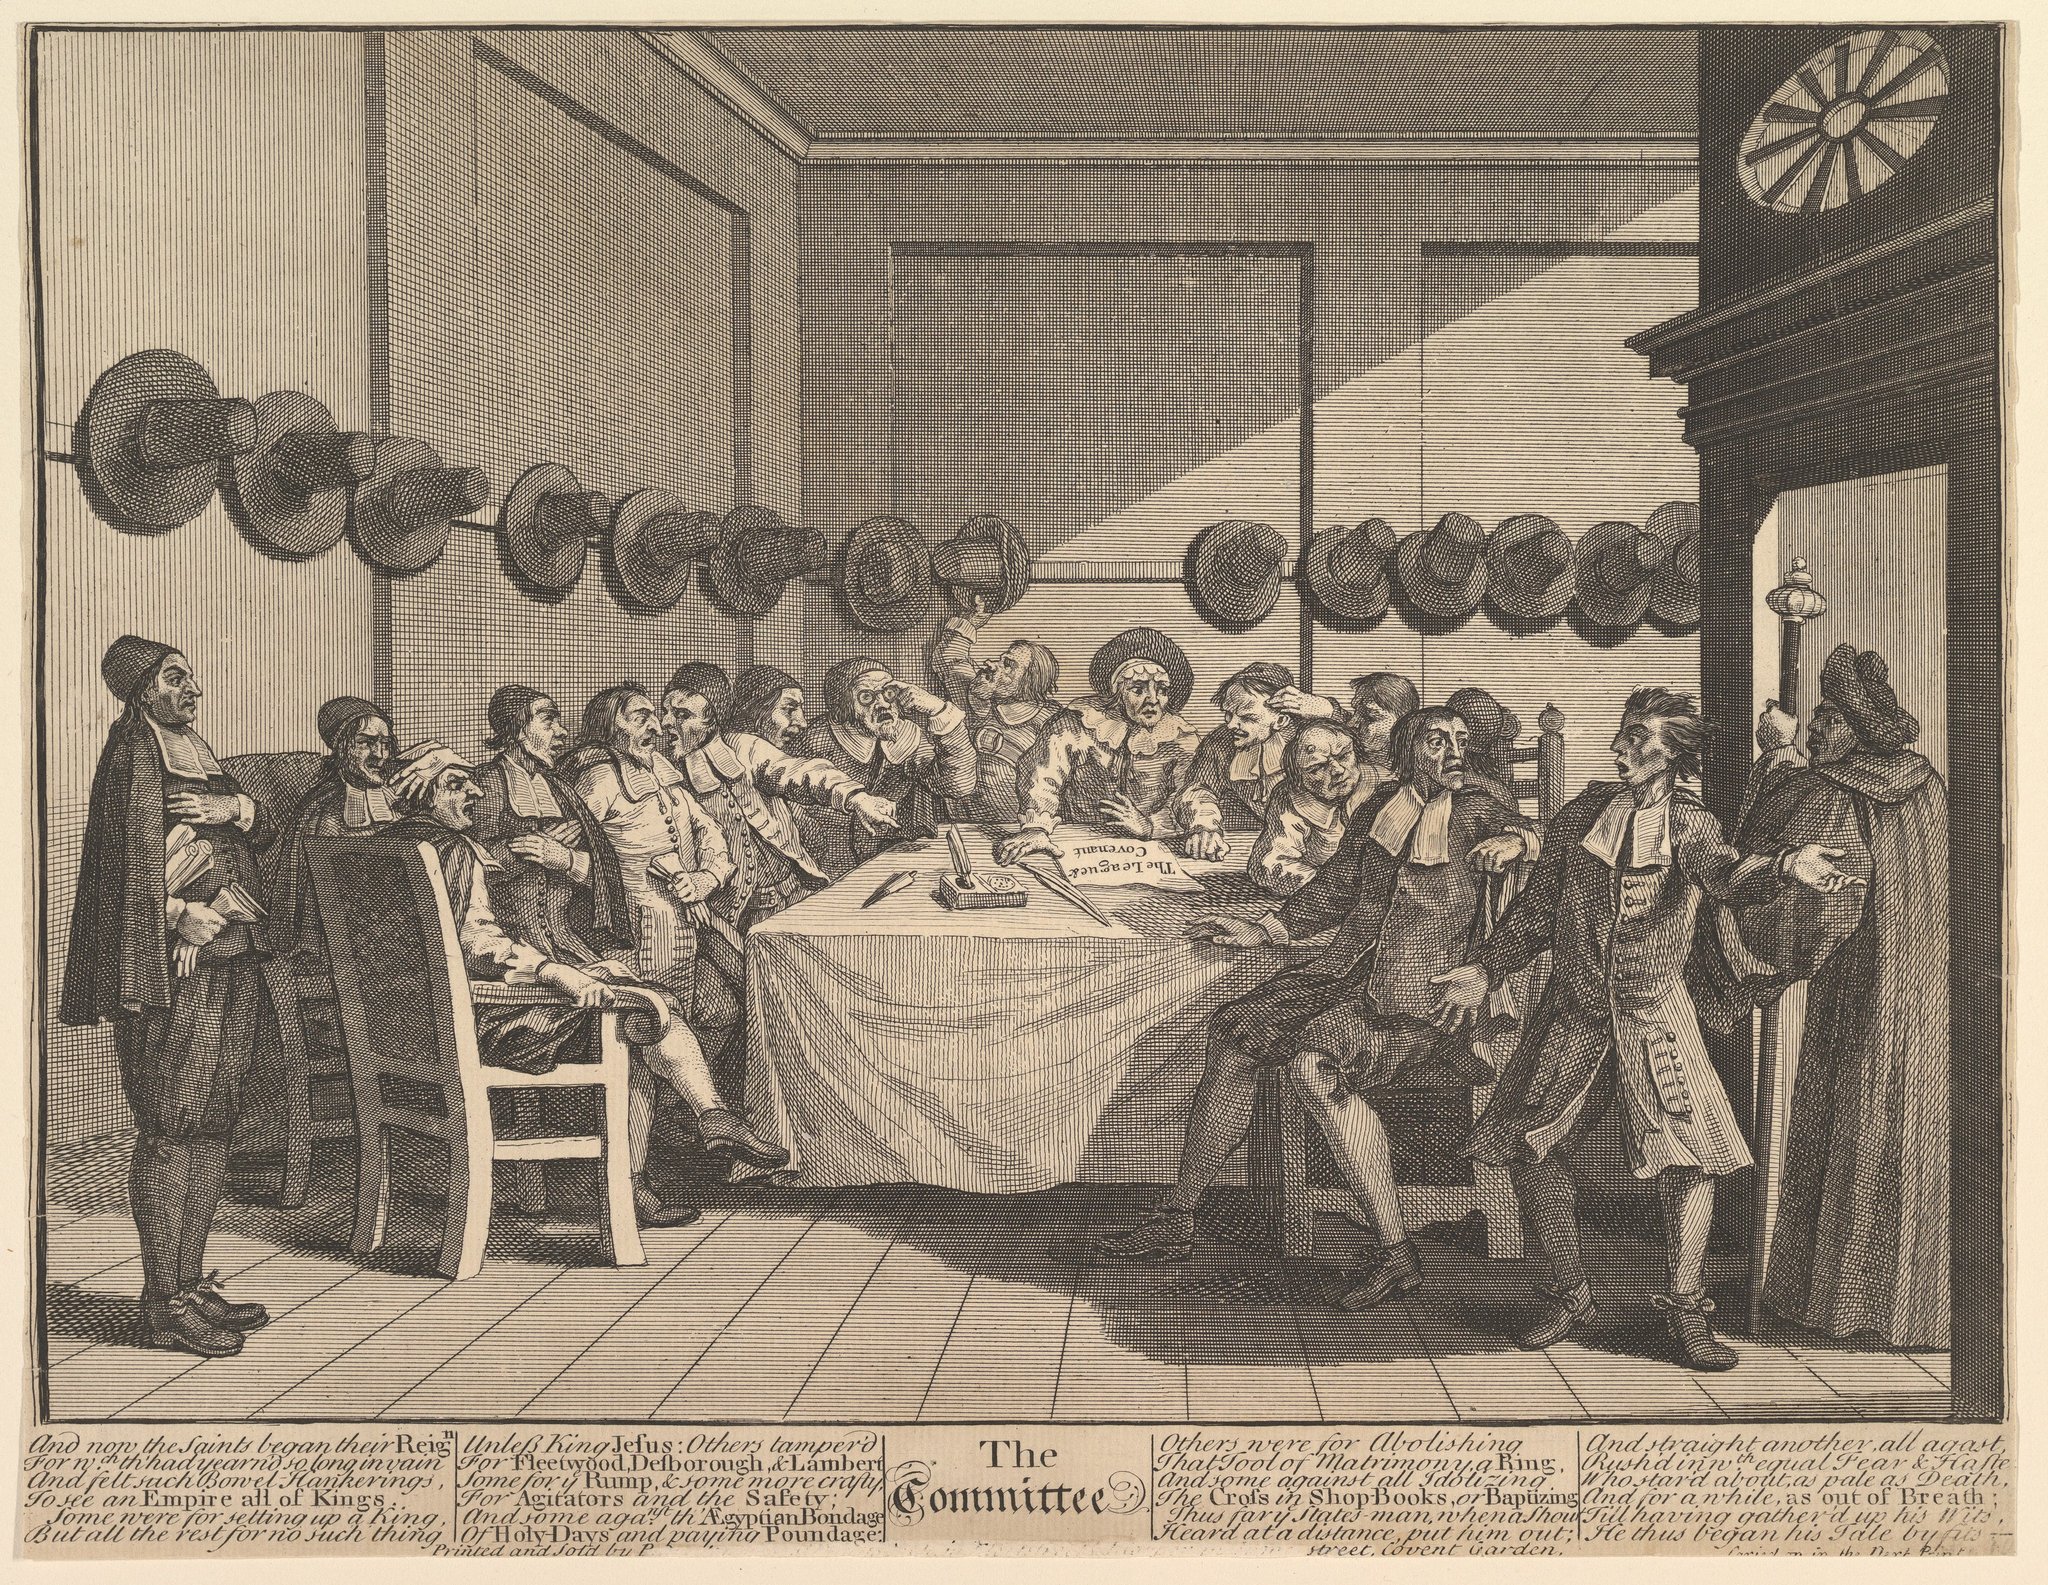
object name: print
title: The Committee (Twelve Large Illustrations for Samuel Butler's Hudibras, Plate 10)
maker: william hogarth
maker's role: artist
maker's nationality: british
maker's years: 1697-1764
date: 1725-1768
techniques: engraving, etching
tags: hats,men